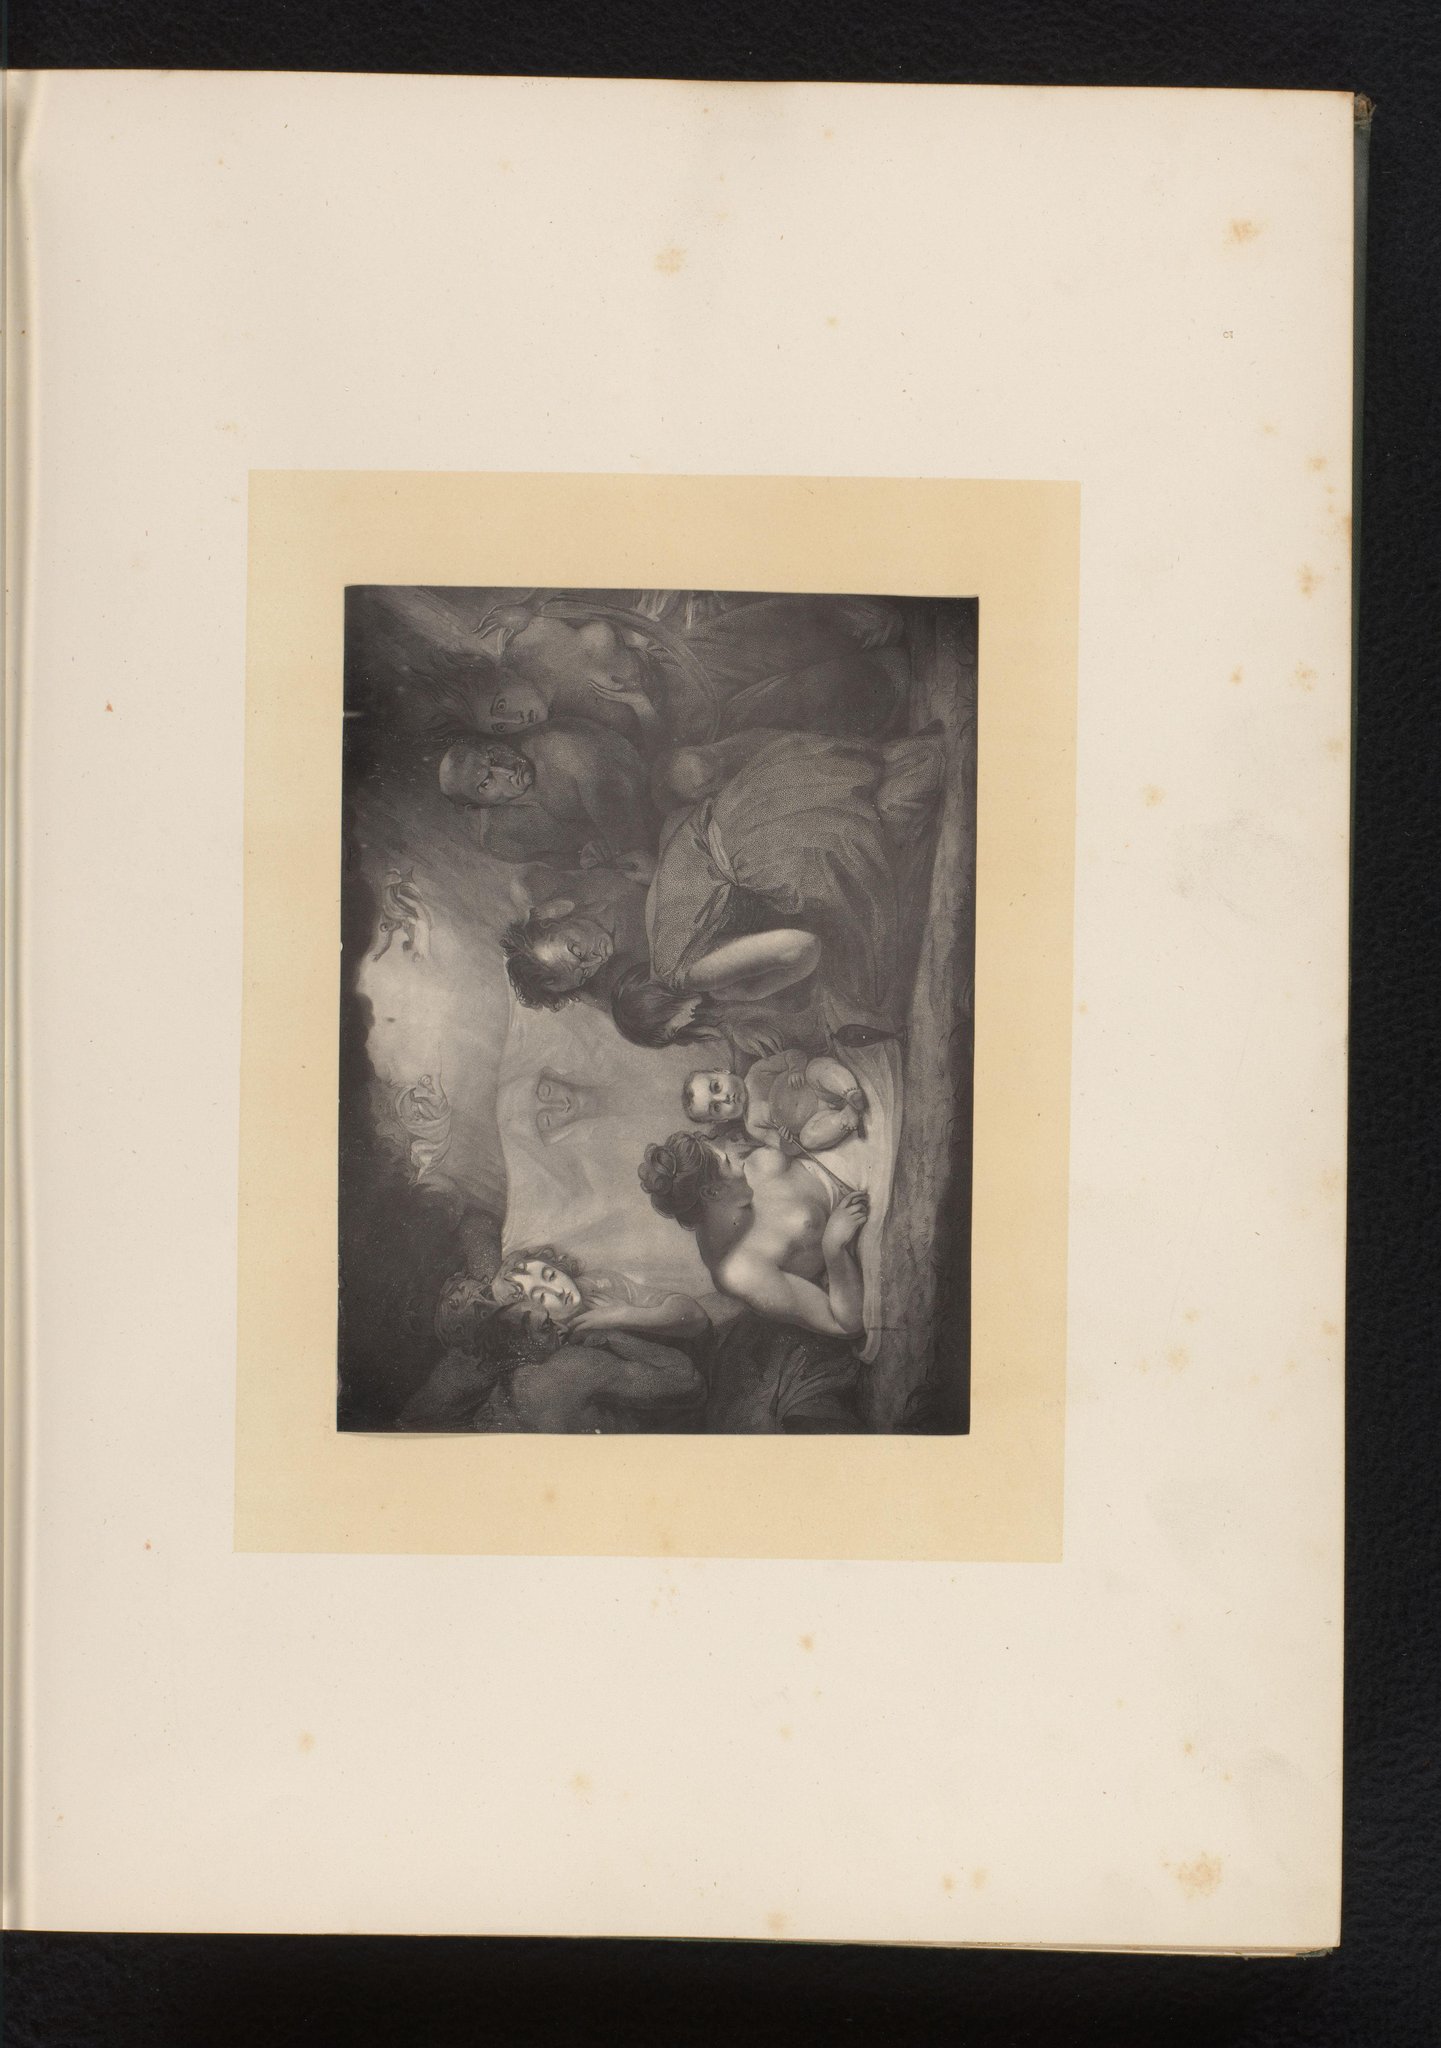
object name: page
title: Reproductie van een gravure naar een schilderij van Shakespeare die als kind bezocht wordt door de Natuur en Passies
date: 1874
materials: paper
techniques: woodburytype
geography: london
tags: william shakespeare, infancy (alleg.), inspiration of the poet; 'furore poetico' (ripa)